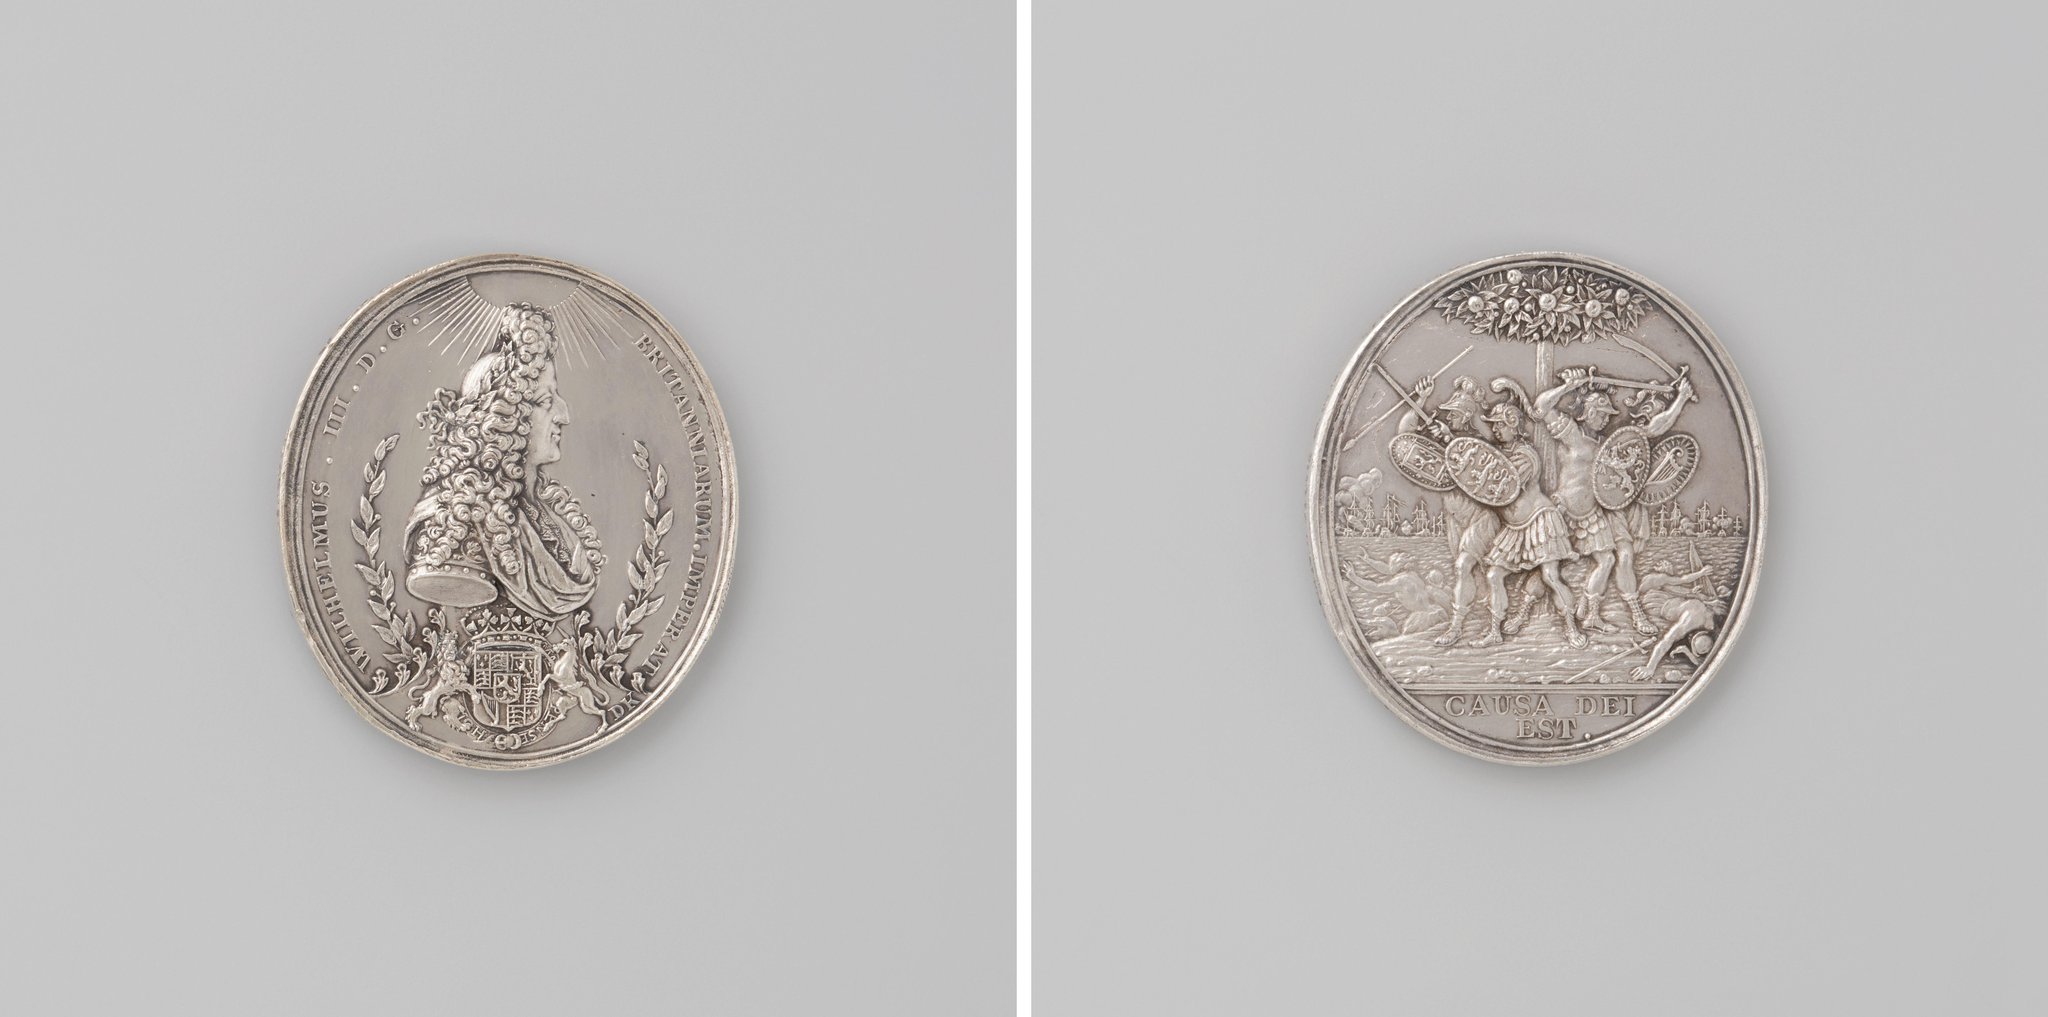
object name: history medal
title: Willem III's troon gevestigd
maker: d. koene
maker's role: die cutter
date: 1691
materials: silver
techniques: striking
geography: netherlands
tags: the hague, william iii (prince of orange and king of england, scotland, and ireland)